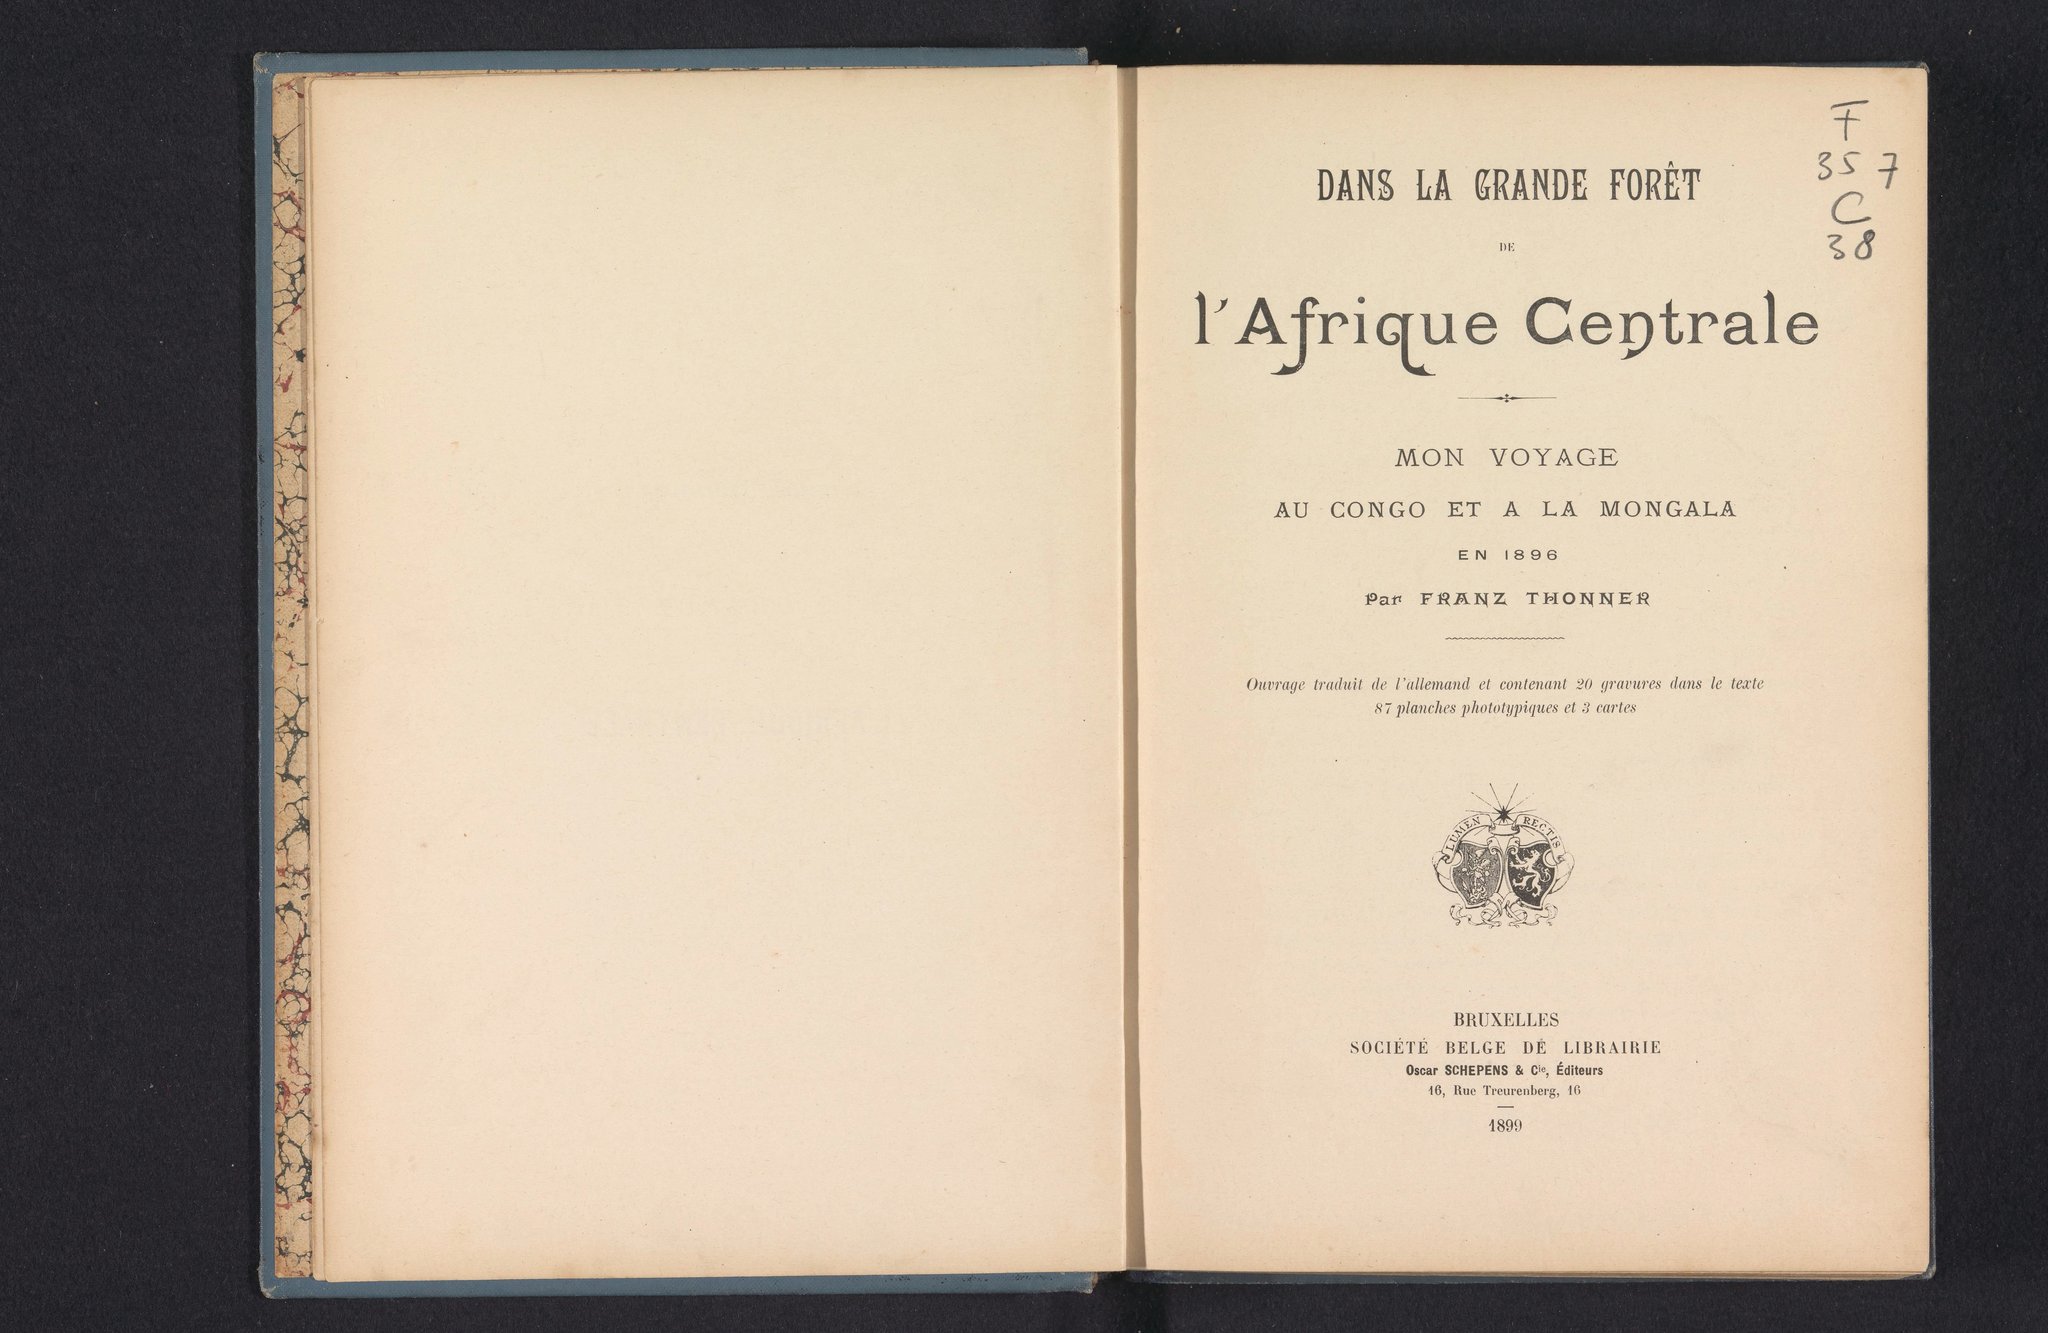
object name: book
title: Dans la Grande forêt de l'Afrique Centrale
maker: franz thonner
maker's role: botanicus, ontdekkingsreiziger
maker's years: 1863-1928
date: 1899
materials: cardboard, linen, paper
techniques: photograph, lithograph, printing, marbling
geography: brussels